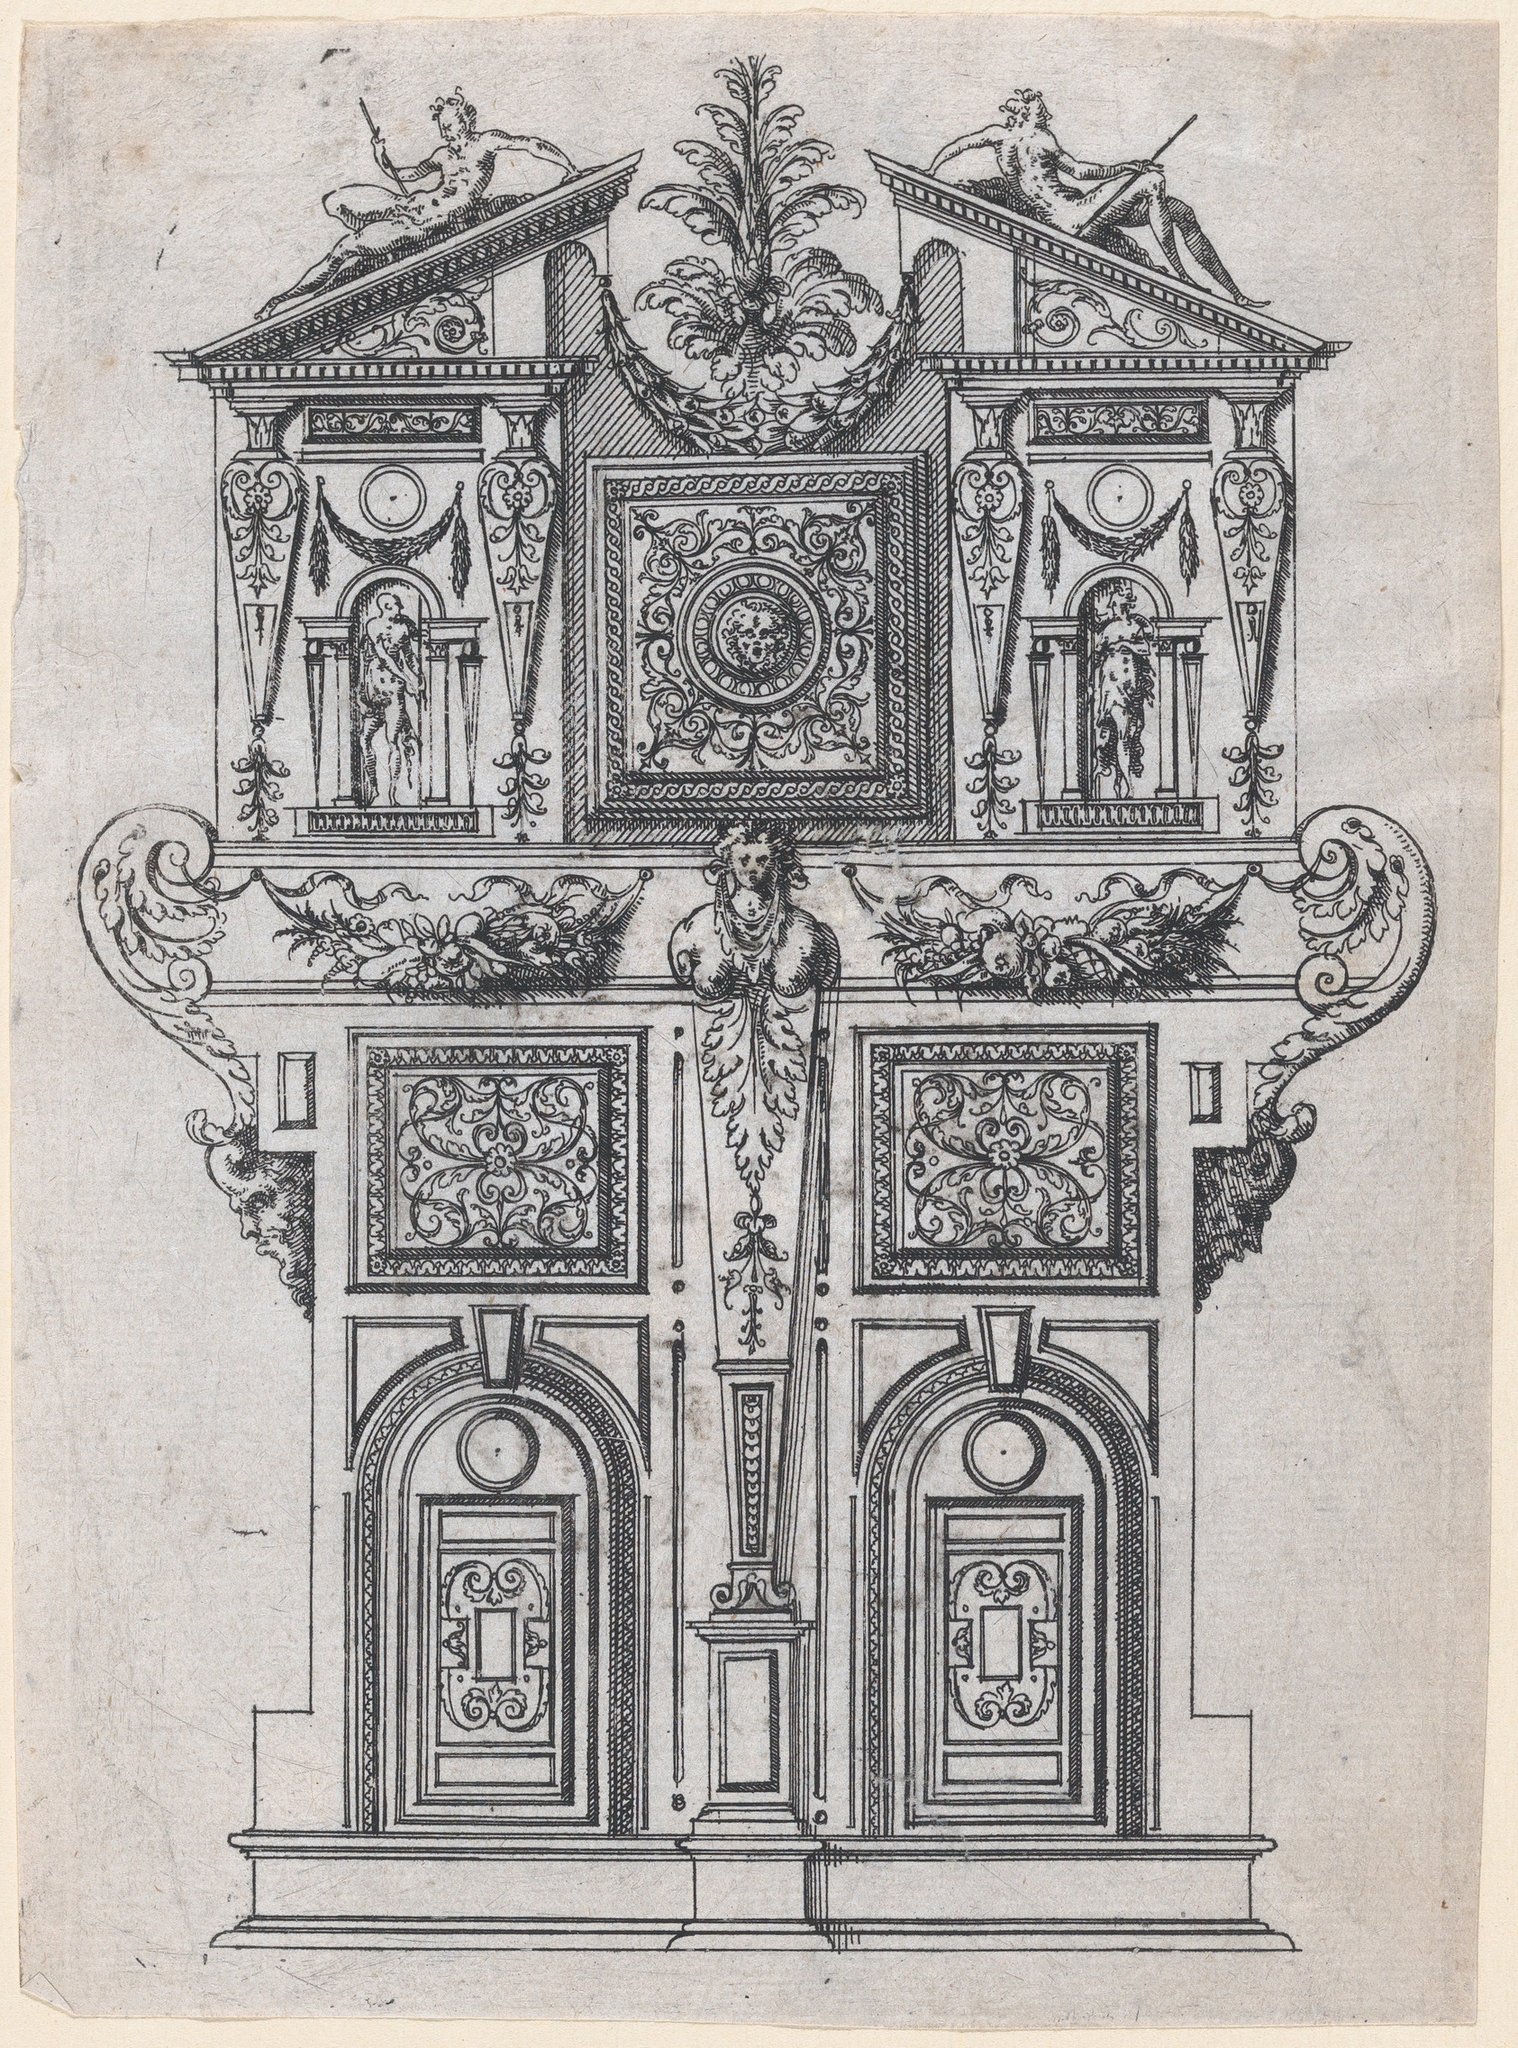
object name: print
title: Furniture Design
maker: jacques androuet du cerceau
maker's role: artist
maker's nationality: french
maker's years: 1510-1585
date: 1565-1570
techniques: etching